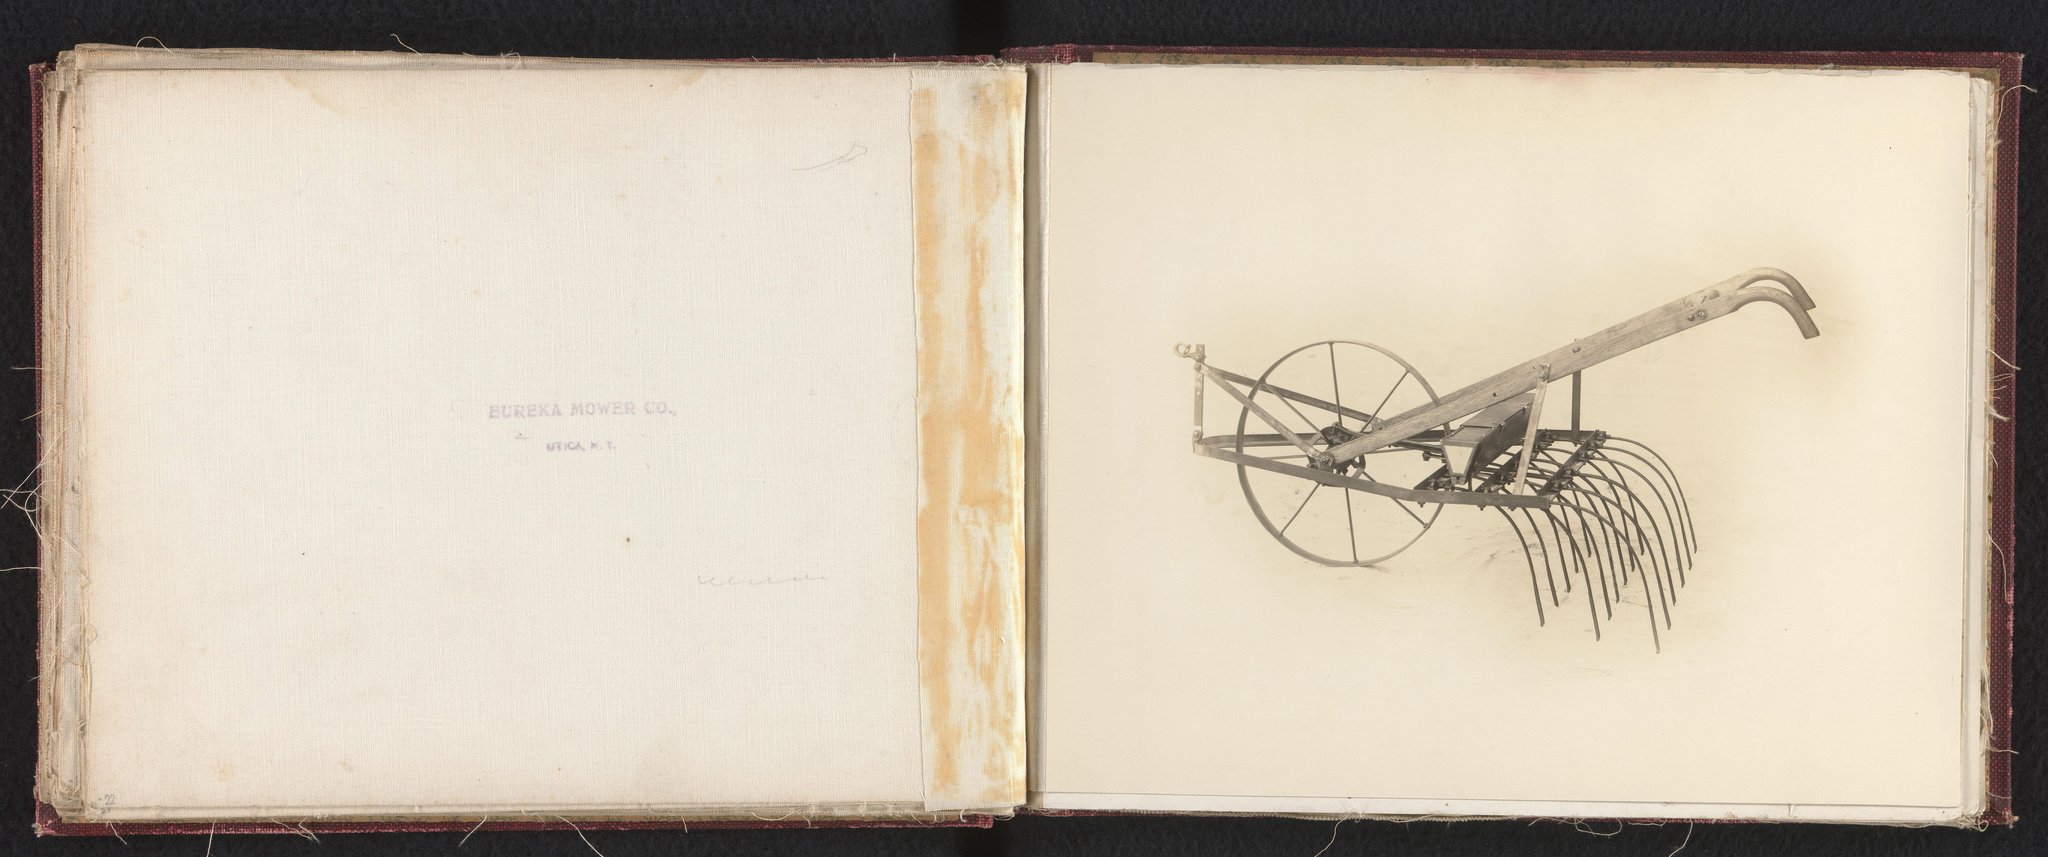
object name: photograph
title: Landbouwwerktuig van de Eureka Mower Co. te Utrica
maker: lewis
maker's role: fotograaf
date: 1915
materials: paper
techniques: gelatin silver print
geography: utica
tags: agricultural implements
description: Foto op twintigste ongenummerde pagina na voorplat.